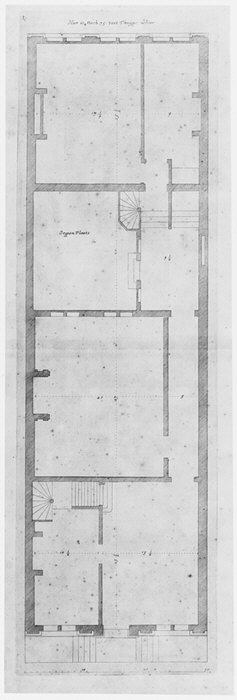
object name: book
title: Afbeelsels der voornaemste gebouwen uyt alle die Philips Vingboons geordineert heeft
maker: philips vingboons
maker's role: author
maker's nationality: dutch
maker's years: 1607-1678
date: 1648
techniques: engraving, etching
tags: architecture